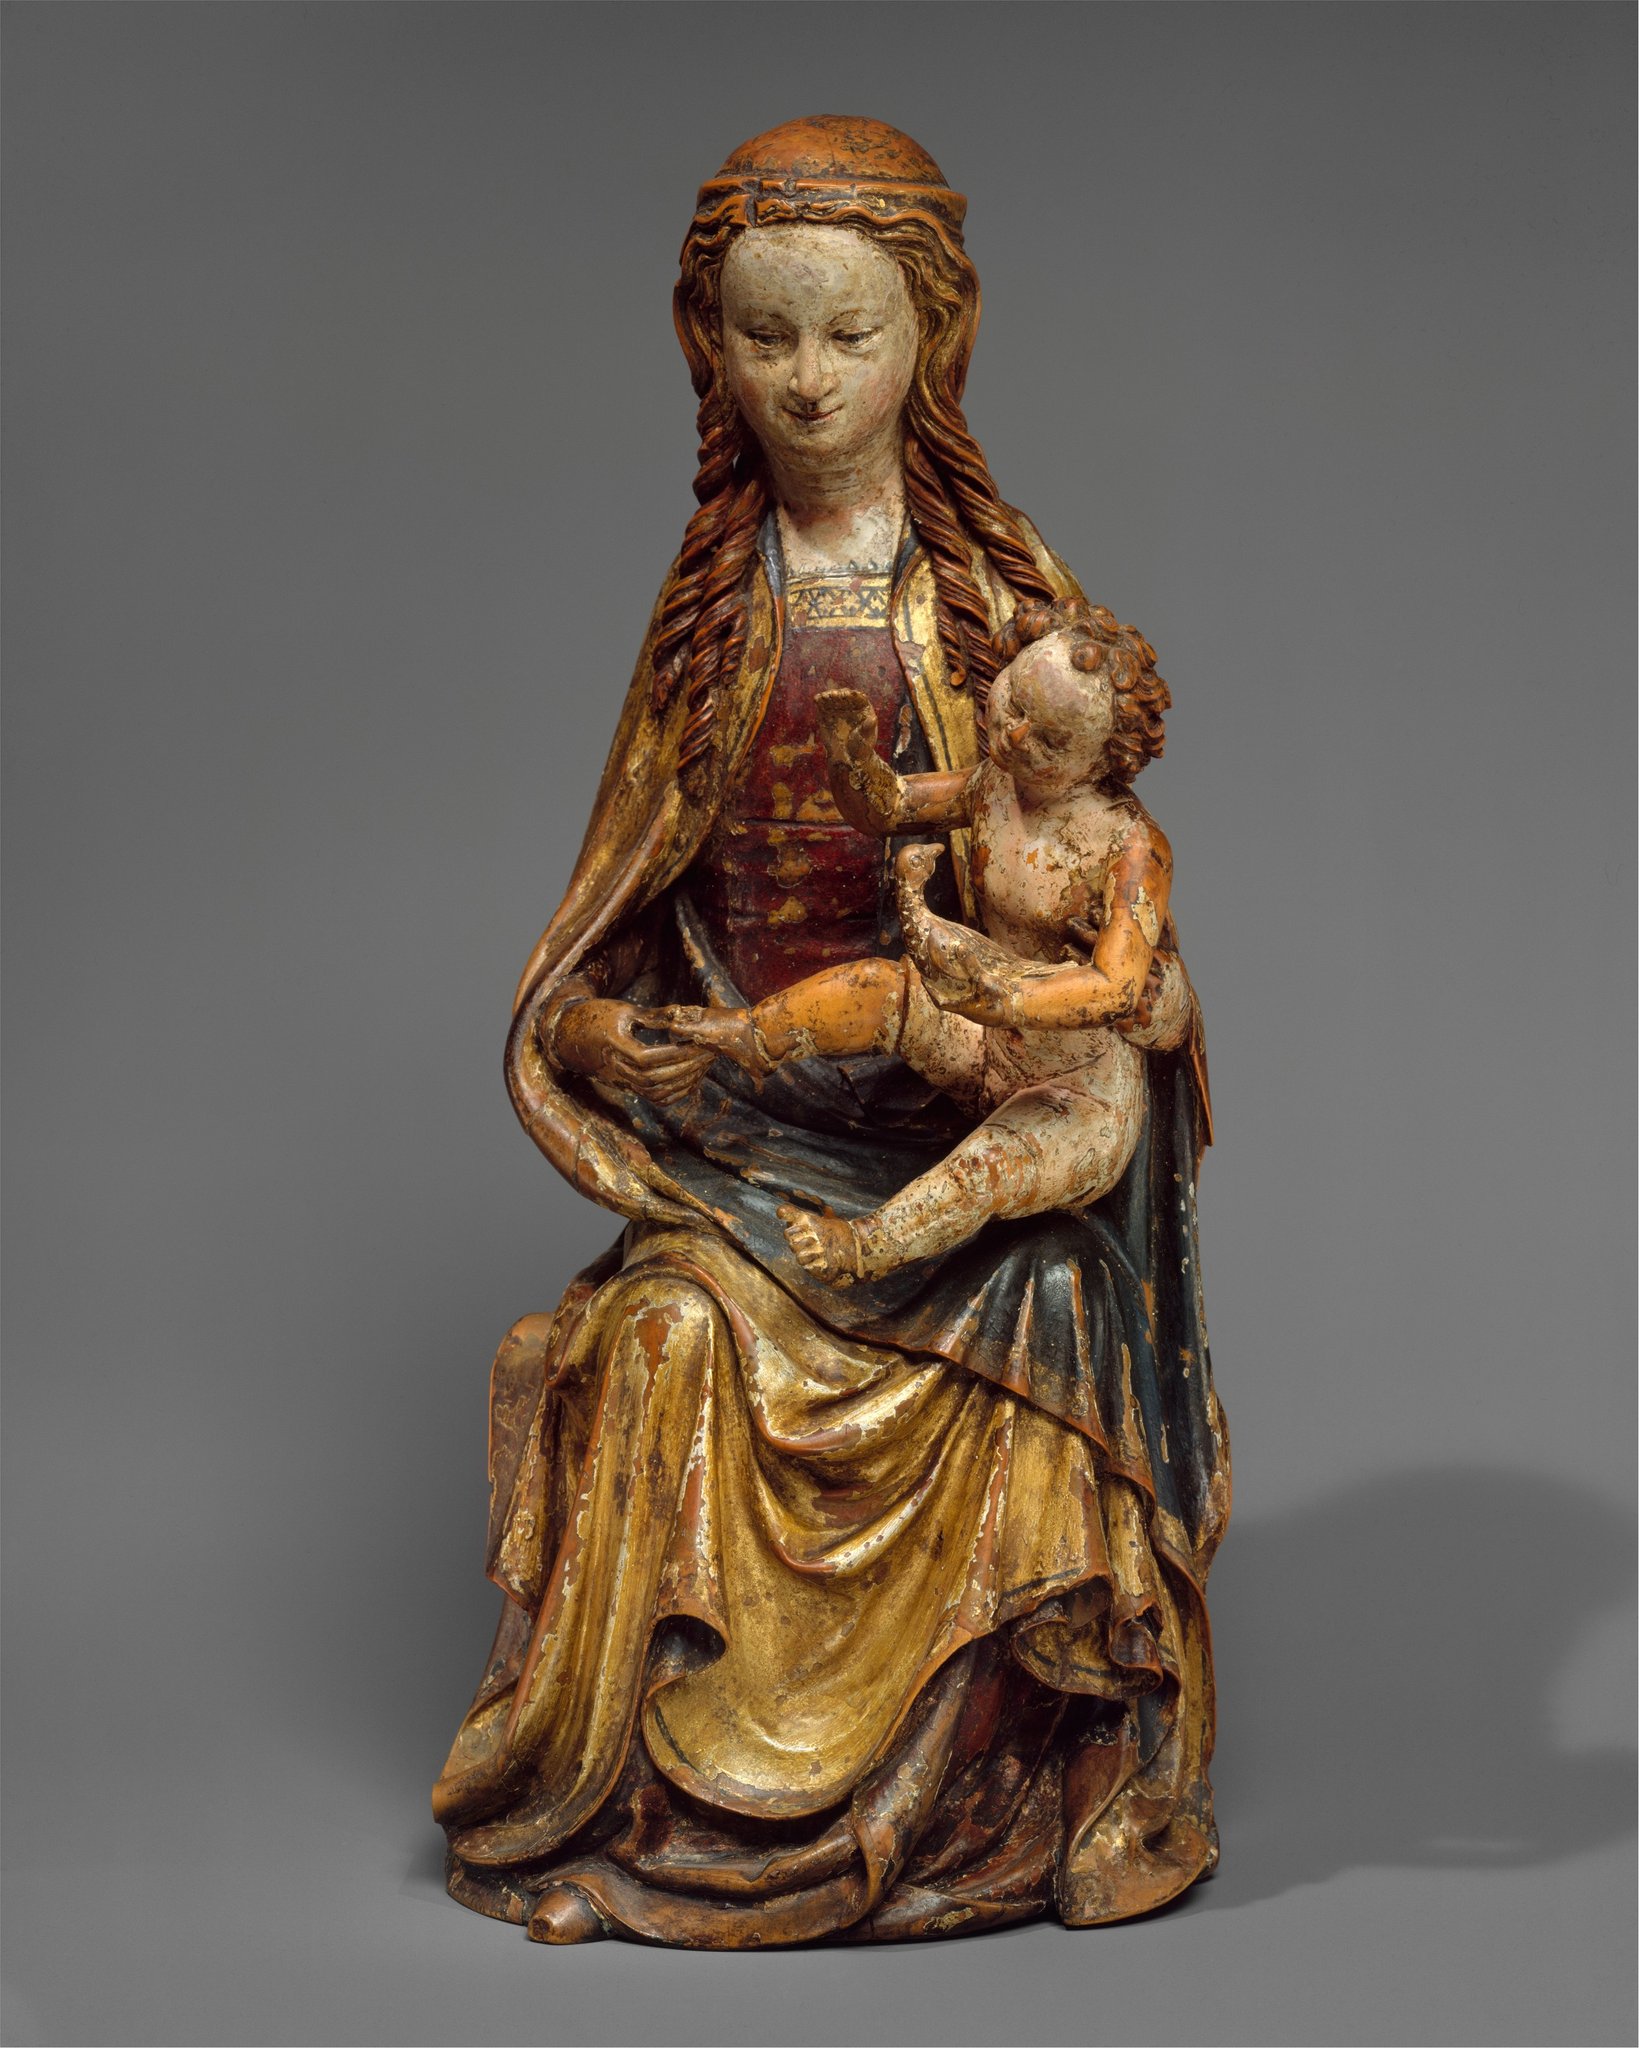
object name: statuette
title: Enthroned Virgin and Child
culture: german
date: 1430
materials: wood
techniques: gilding, polychromy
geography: germany